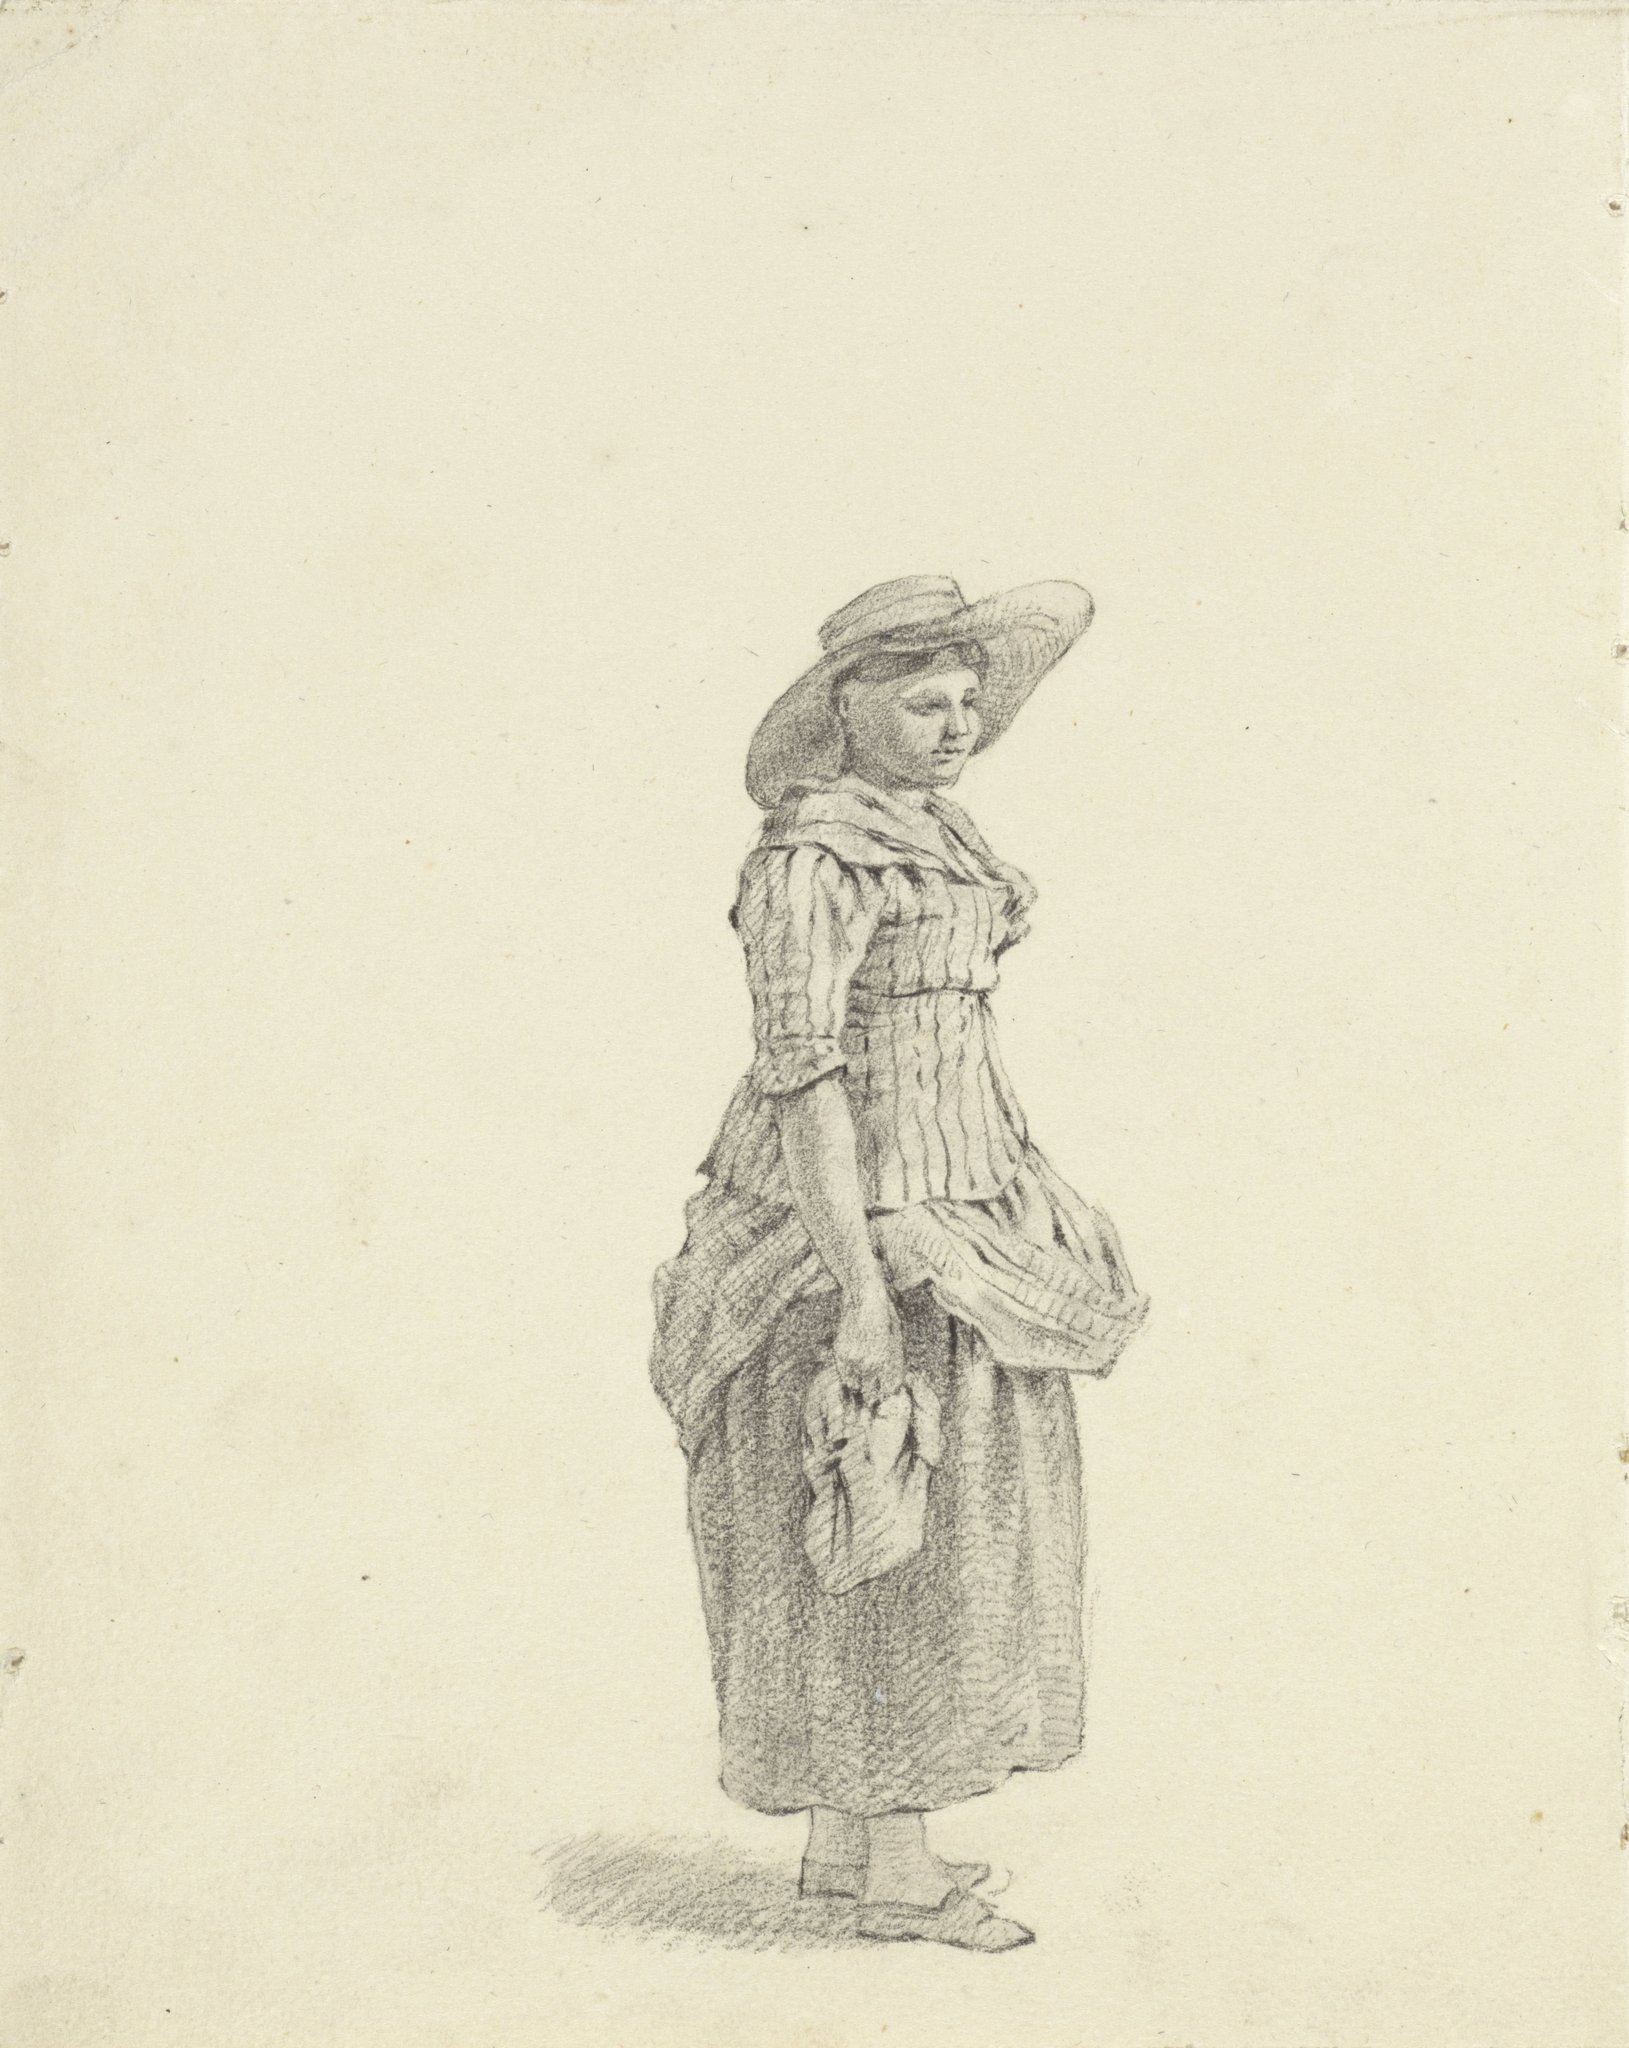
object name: drawing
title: Staande vrouw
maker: pieter van loon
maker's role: draughtsman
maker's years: 1801-1873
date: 1811-1873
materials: chalk, paper